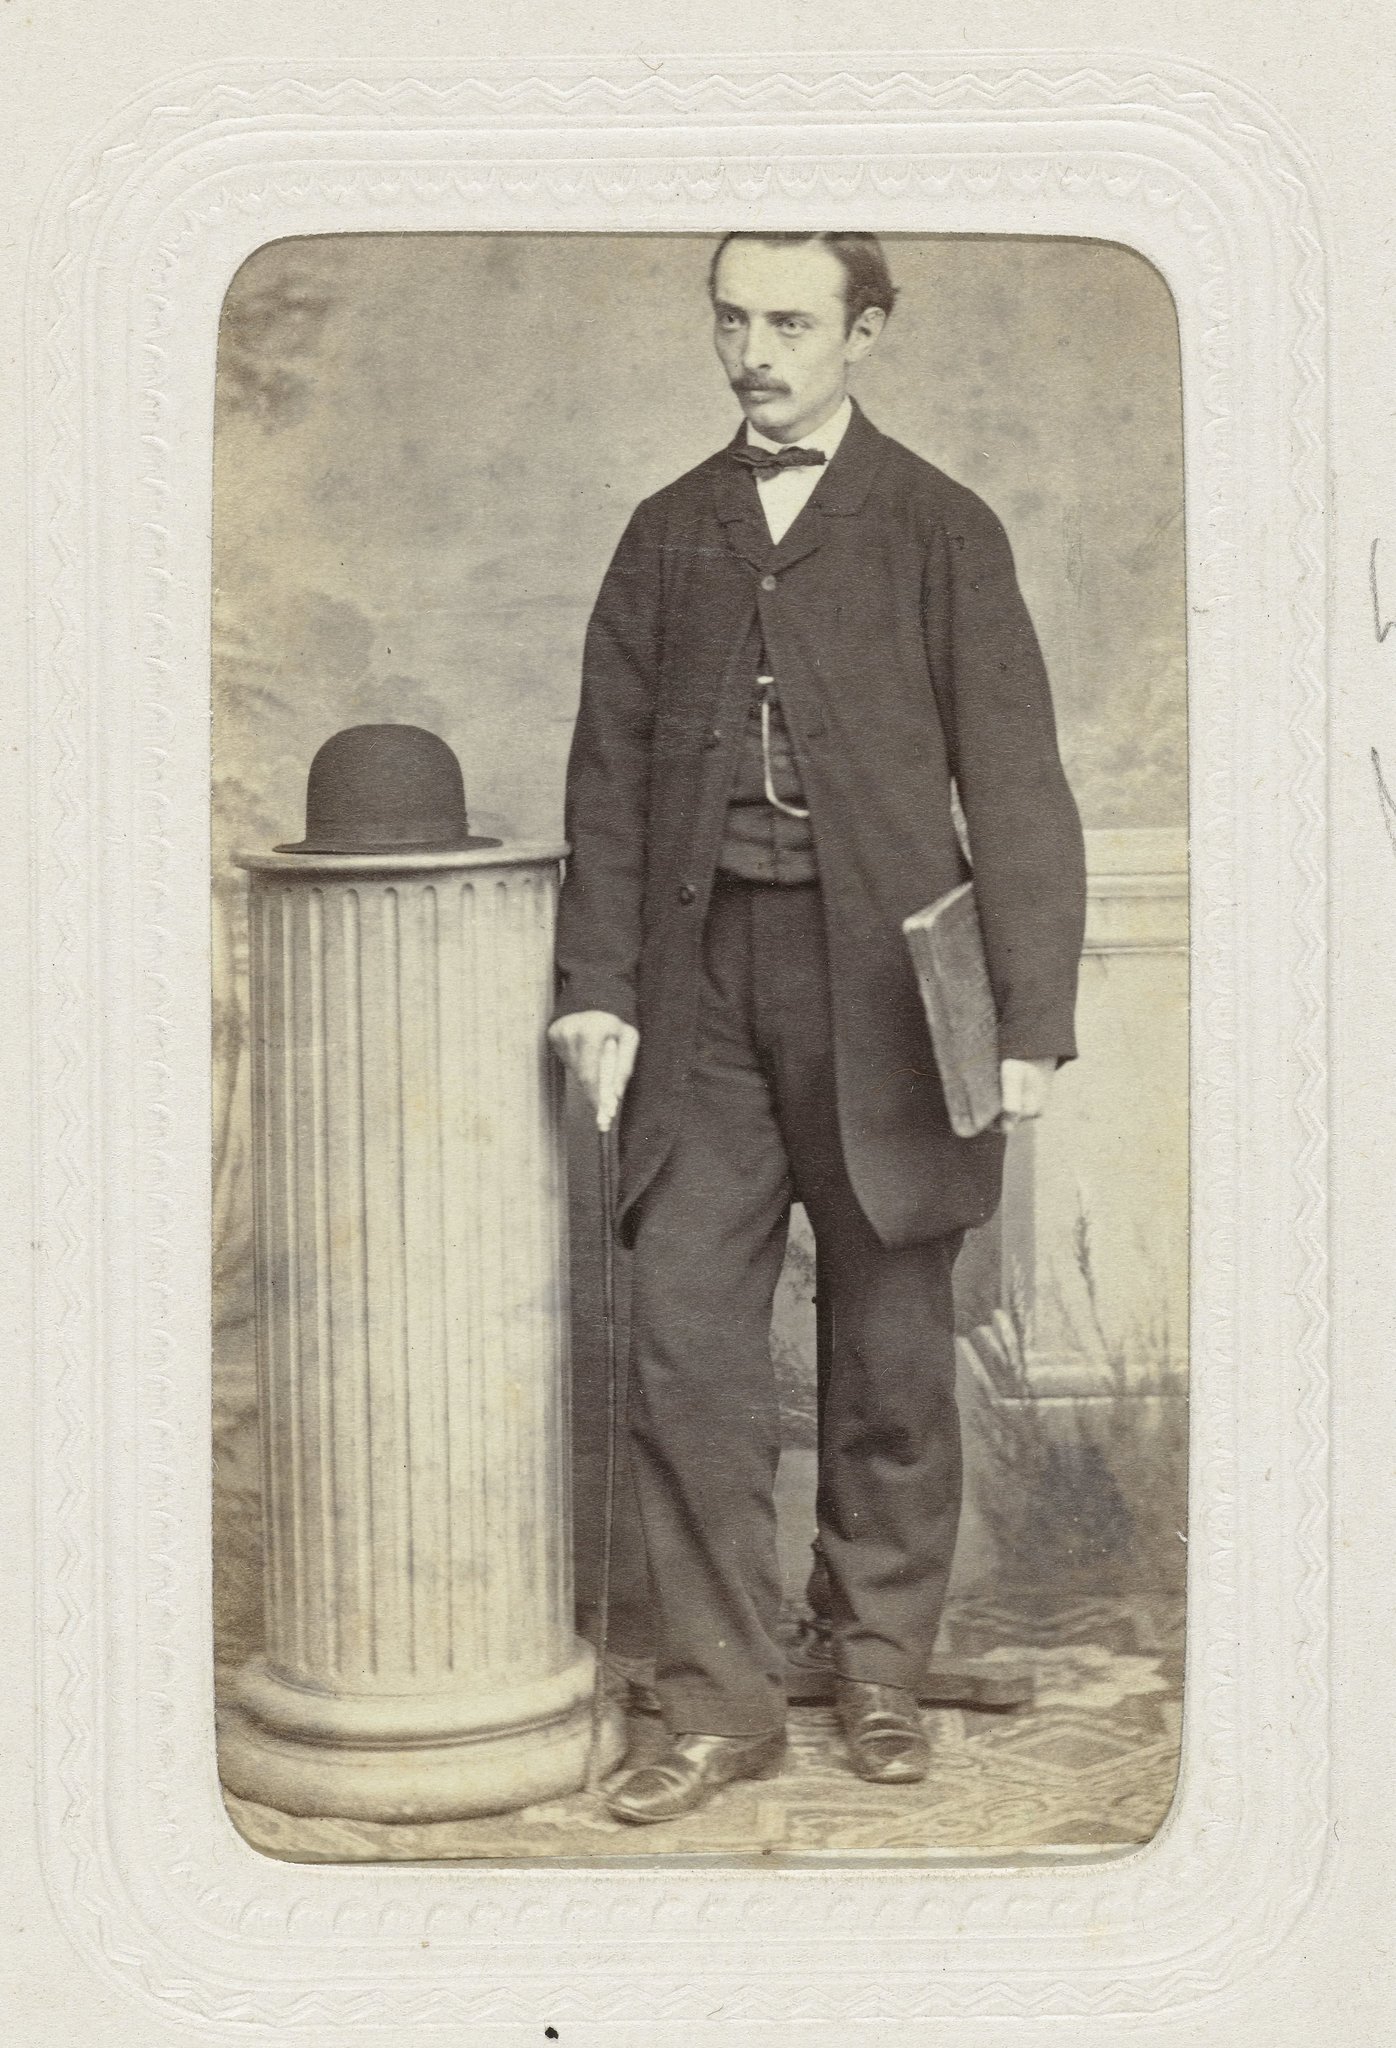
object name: carte de visite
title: Studioportret van een man met snor, wandelstok en bolhoed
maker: louis robert werner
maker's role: fotograaf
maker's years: 1834-1896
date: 1863-1870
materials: cardboard, paper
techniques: albumen print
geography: germany